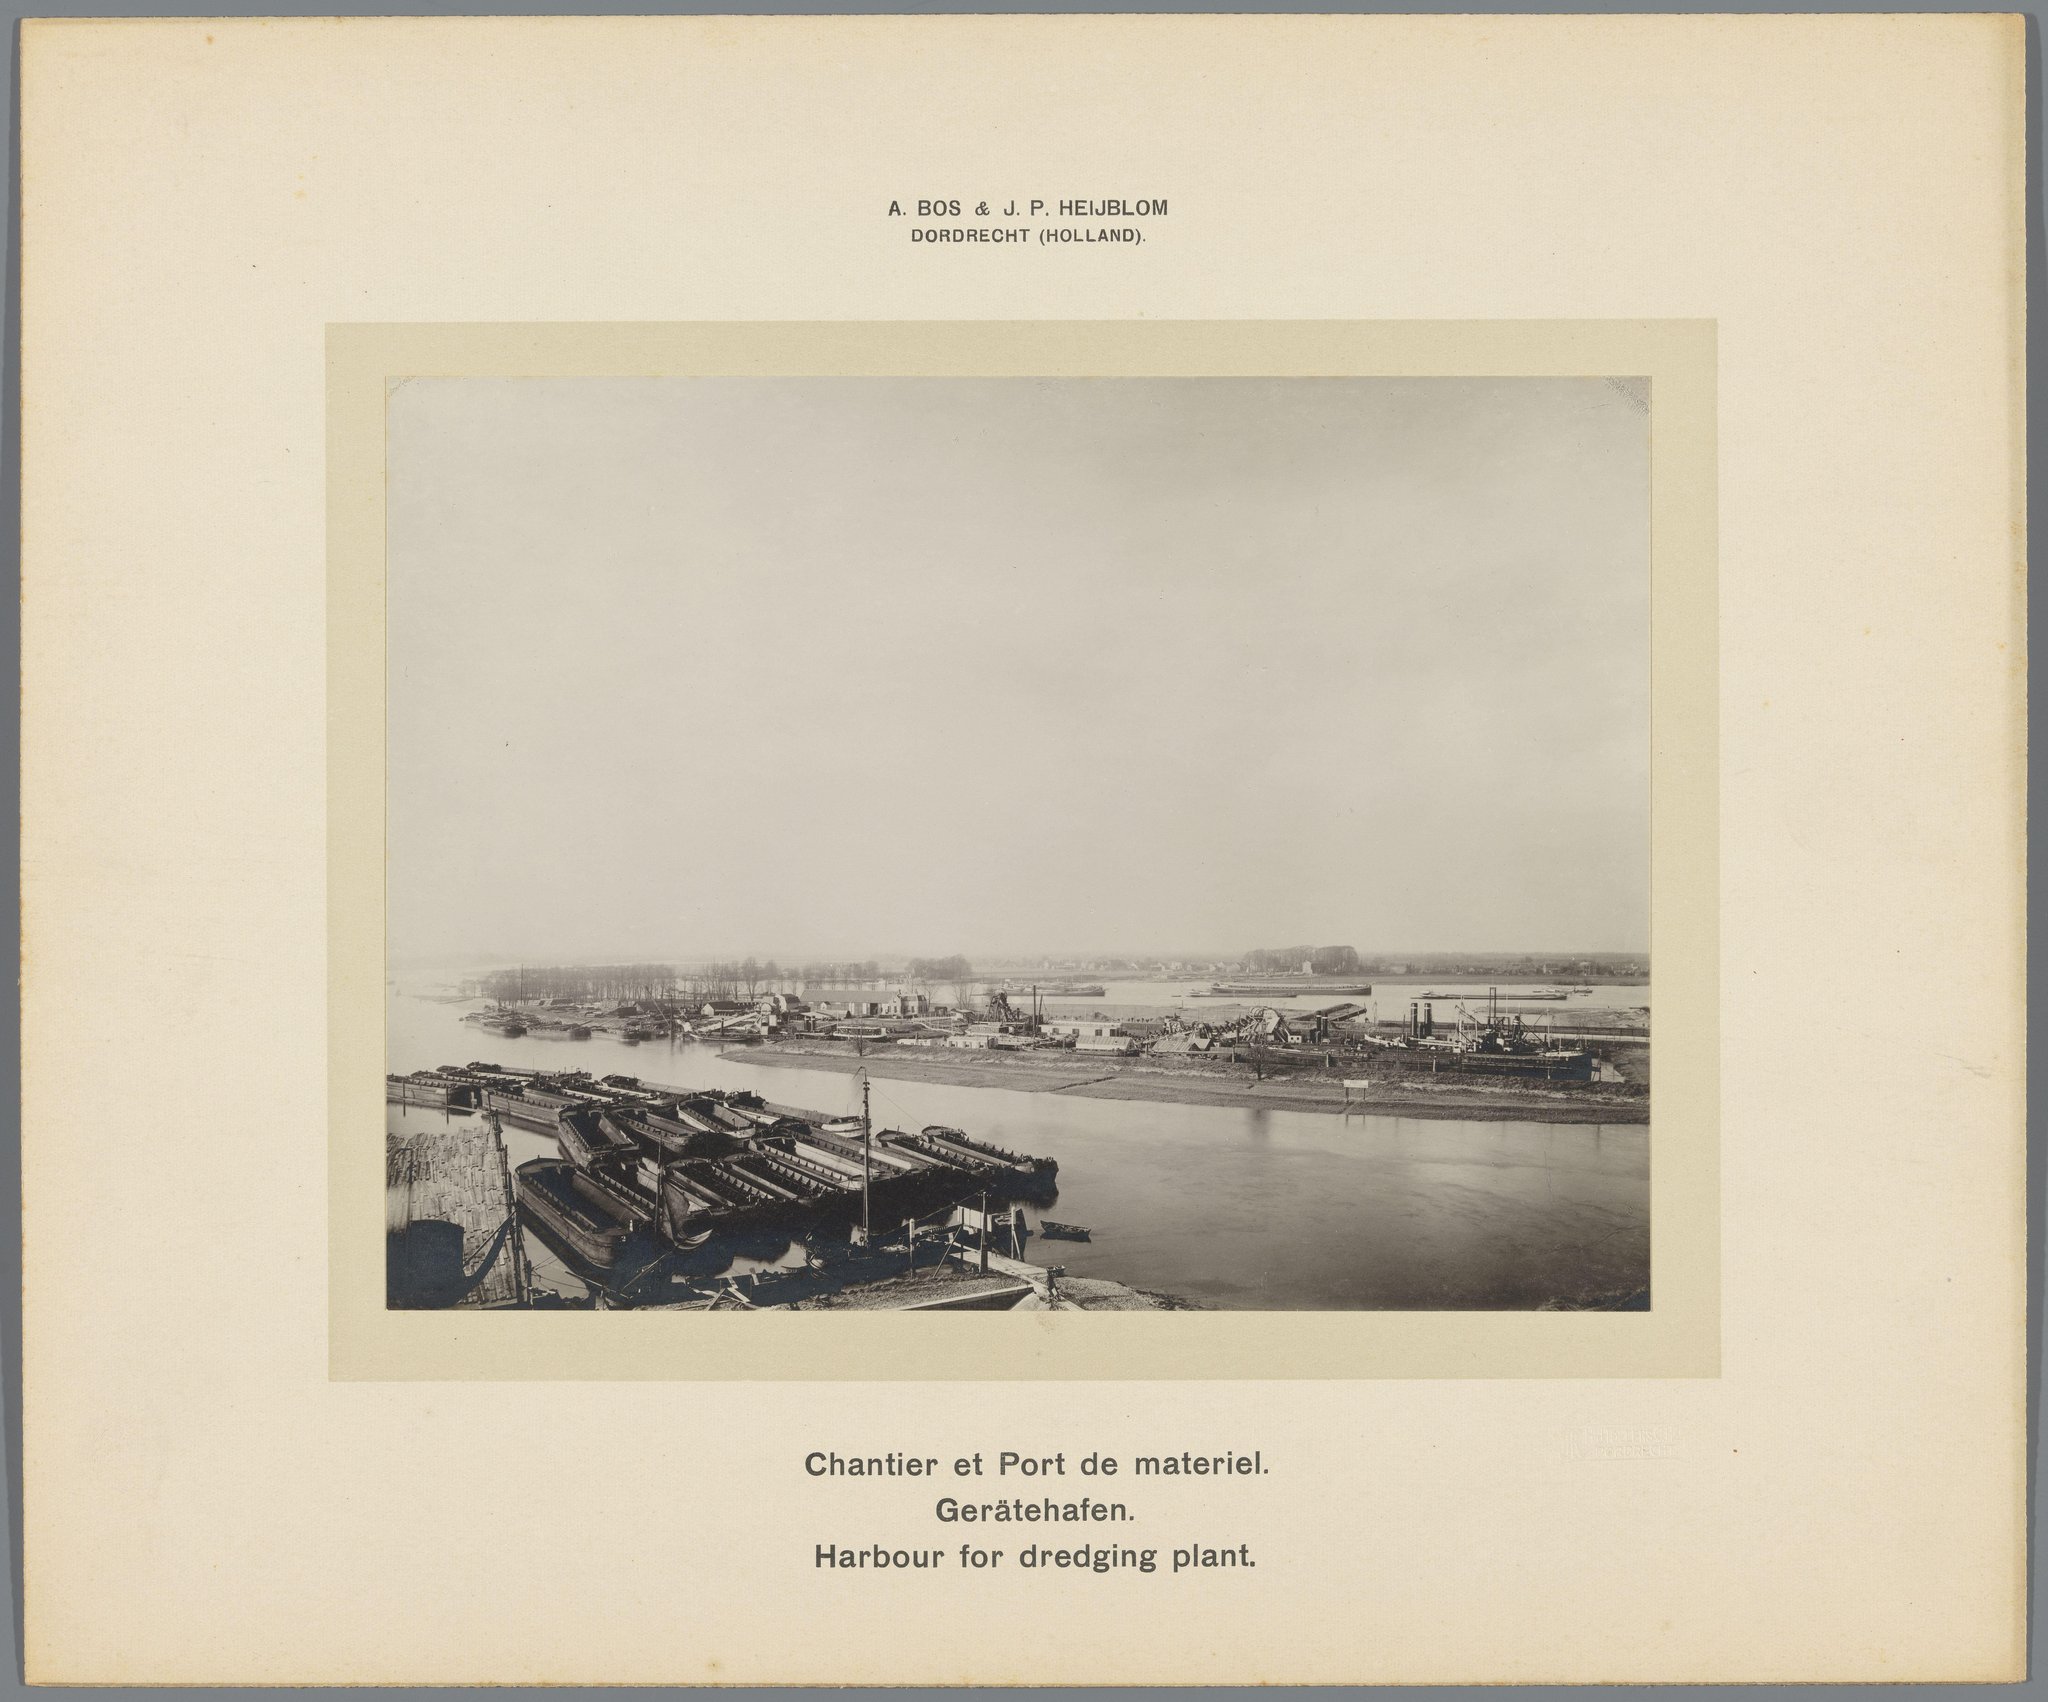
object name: photograph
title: Havengezicht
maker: henricus jacobus tollens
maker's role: painter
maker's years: 1864-1936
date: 1900-1910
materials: cardboard, photographic support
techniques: gelatin silver print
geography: dordrecht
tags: machine driven by steam, steamship, motorship (+ propulsion of vehicle, ship, etc. by steam), dredge, dredging machine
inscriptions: name: ‘H.J. Tollens C. Hzn. Dordrecht’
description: Gezicht op de haven. Foto geplakt op karton met onderschrift in Frans, Duits en Engels. Onderdeel van de map met 44 foto's van baggerschepen van de firma A. Bos & J.P. Heijblom te Dordrecht.